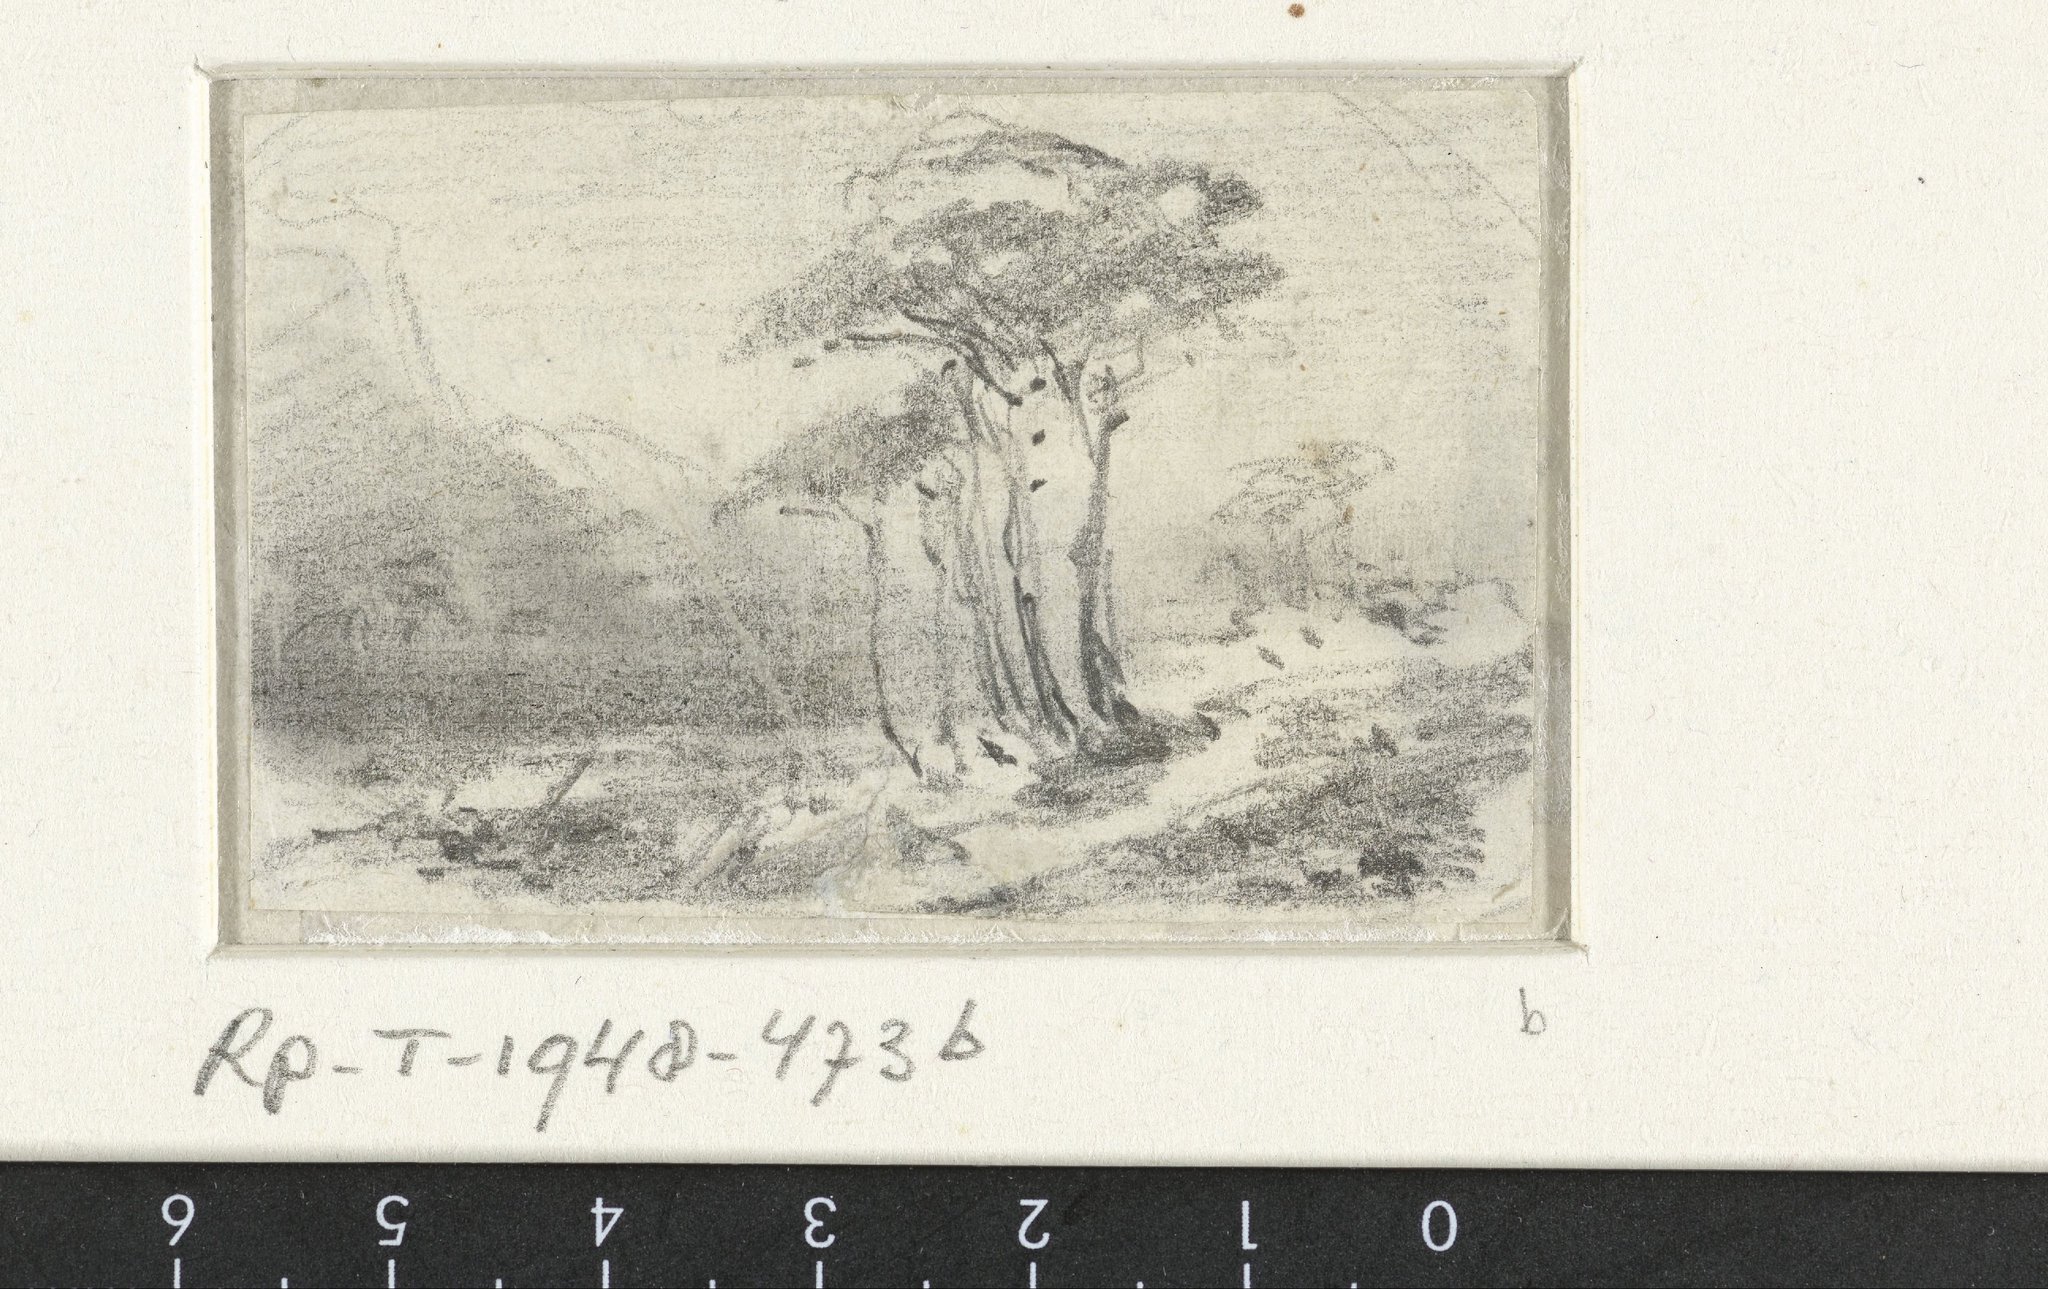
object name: drawing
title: Landschap met bomengroep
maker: maxime françois antoine lalanne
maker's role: draughtsman, print maker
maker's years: 1827-1886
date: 1837-1886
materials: paper, pencil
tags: groups of trees